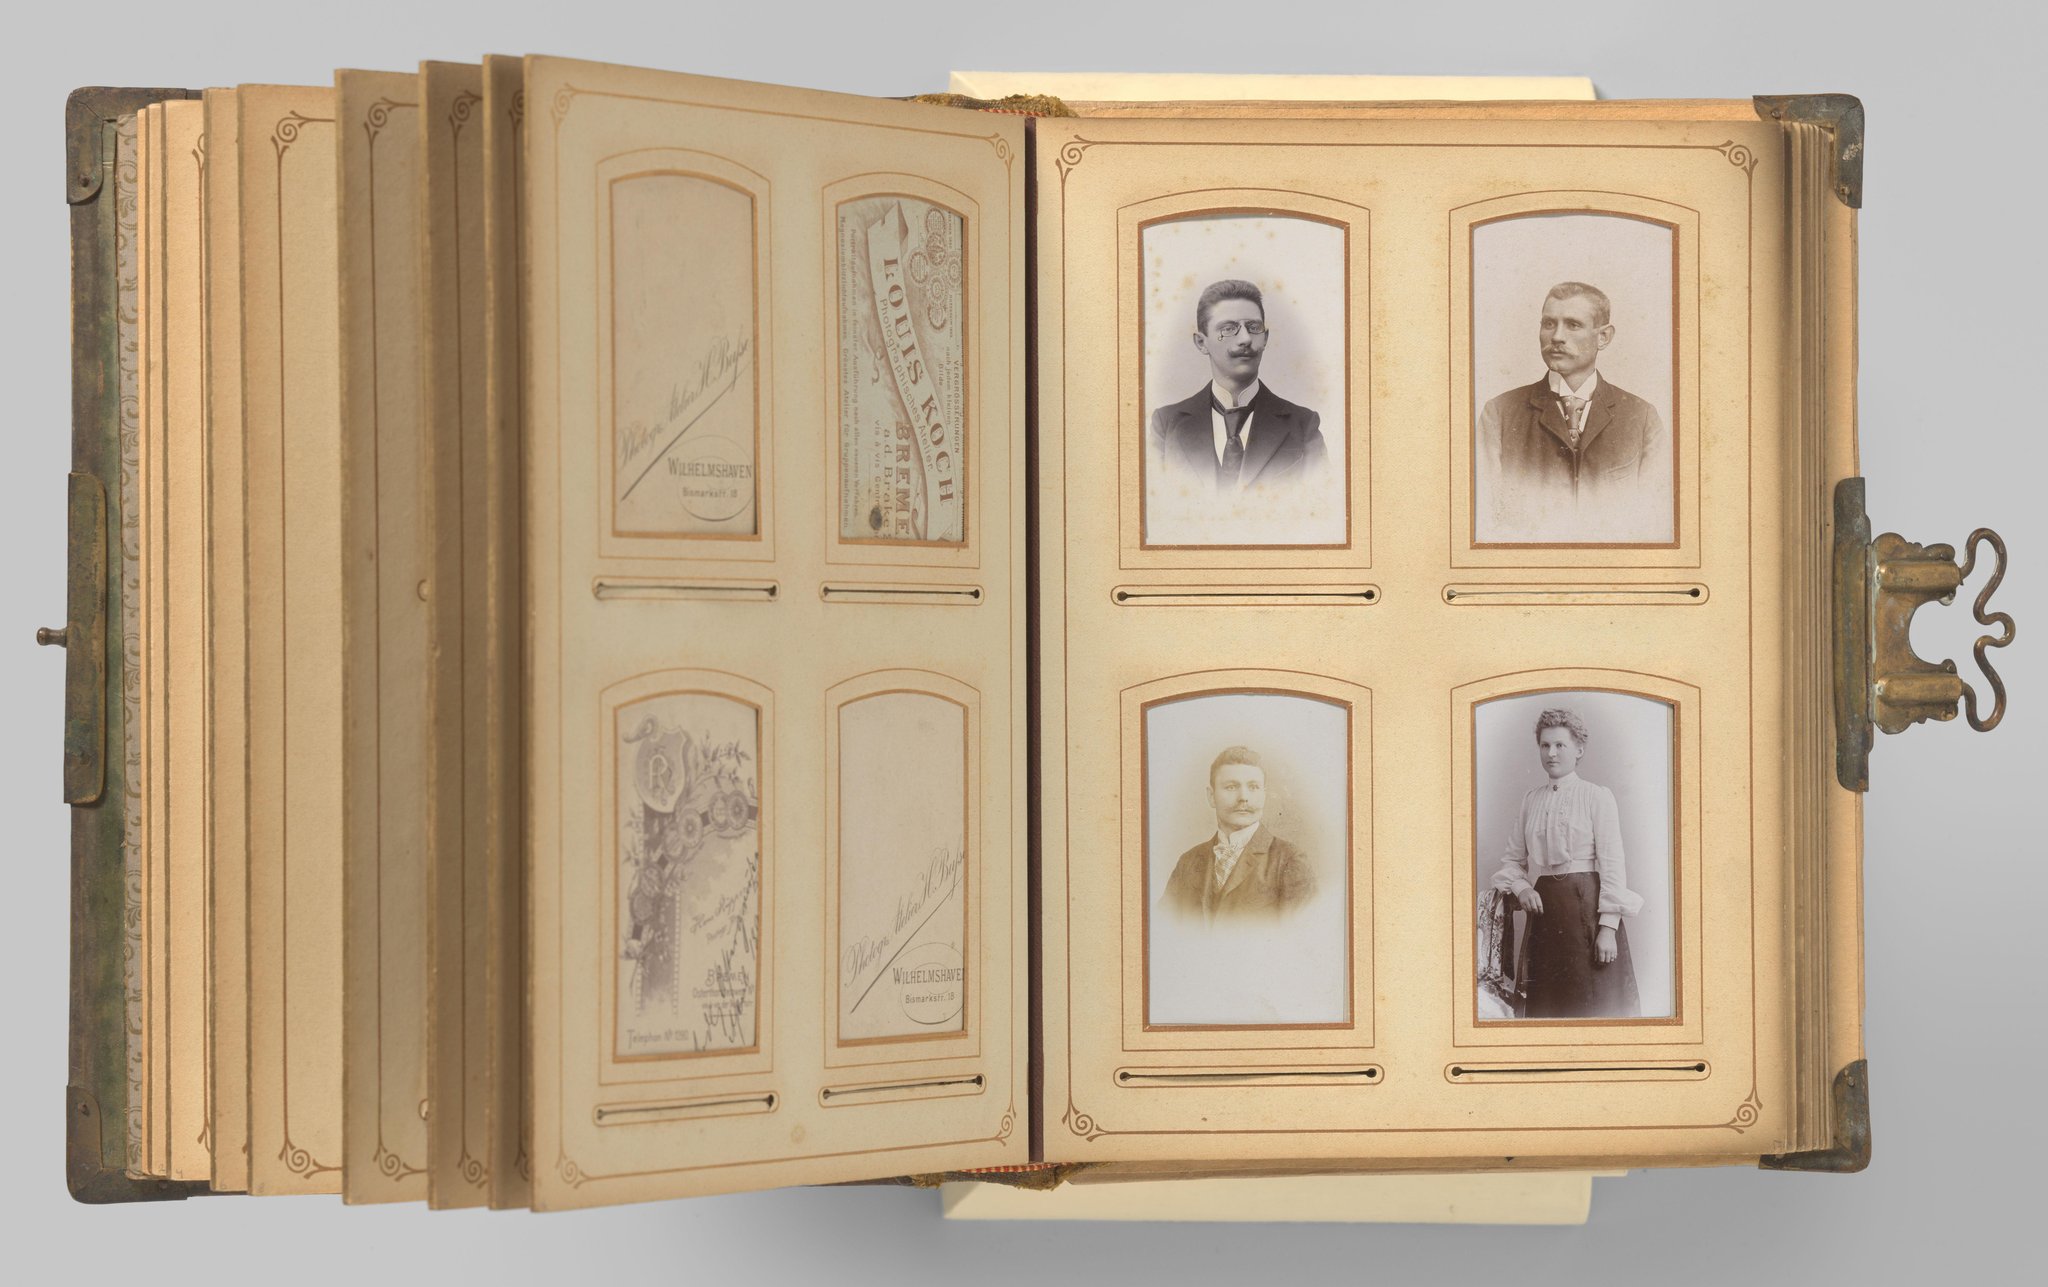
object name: album leaf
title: Portret van een man met bril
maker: a. bender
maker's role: fotograaf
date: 1880-1920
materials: cardboard, photographic support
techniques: collodion silver print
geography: bremen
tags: eyeglasses, spectacles, historical persons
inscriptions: inscription: ‘A. Bender/ Photogr. Atelier/ Bremen/ Lützowerstr. [...]’